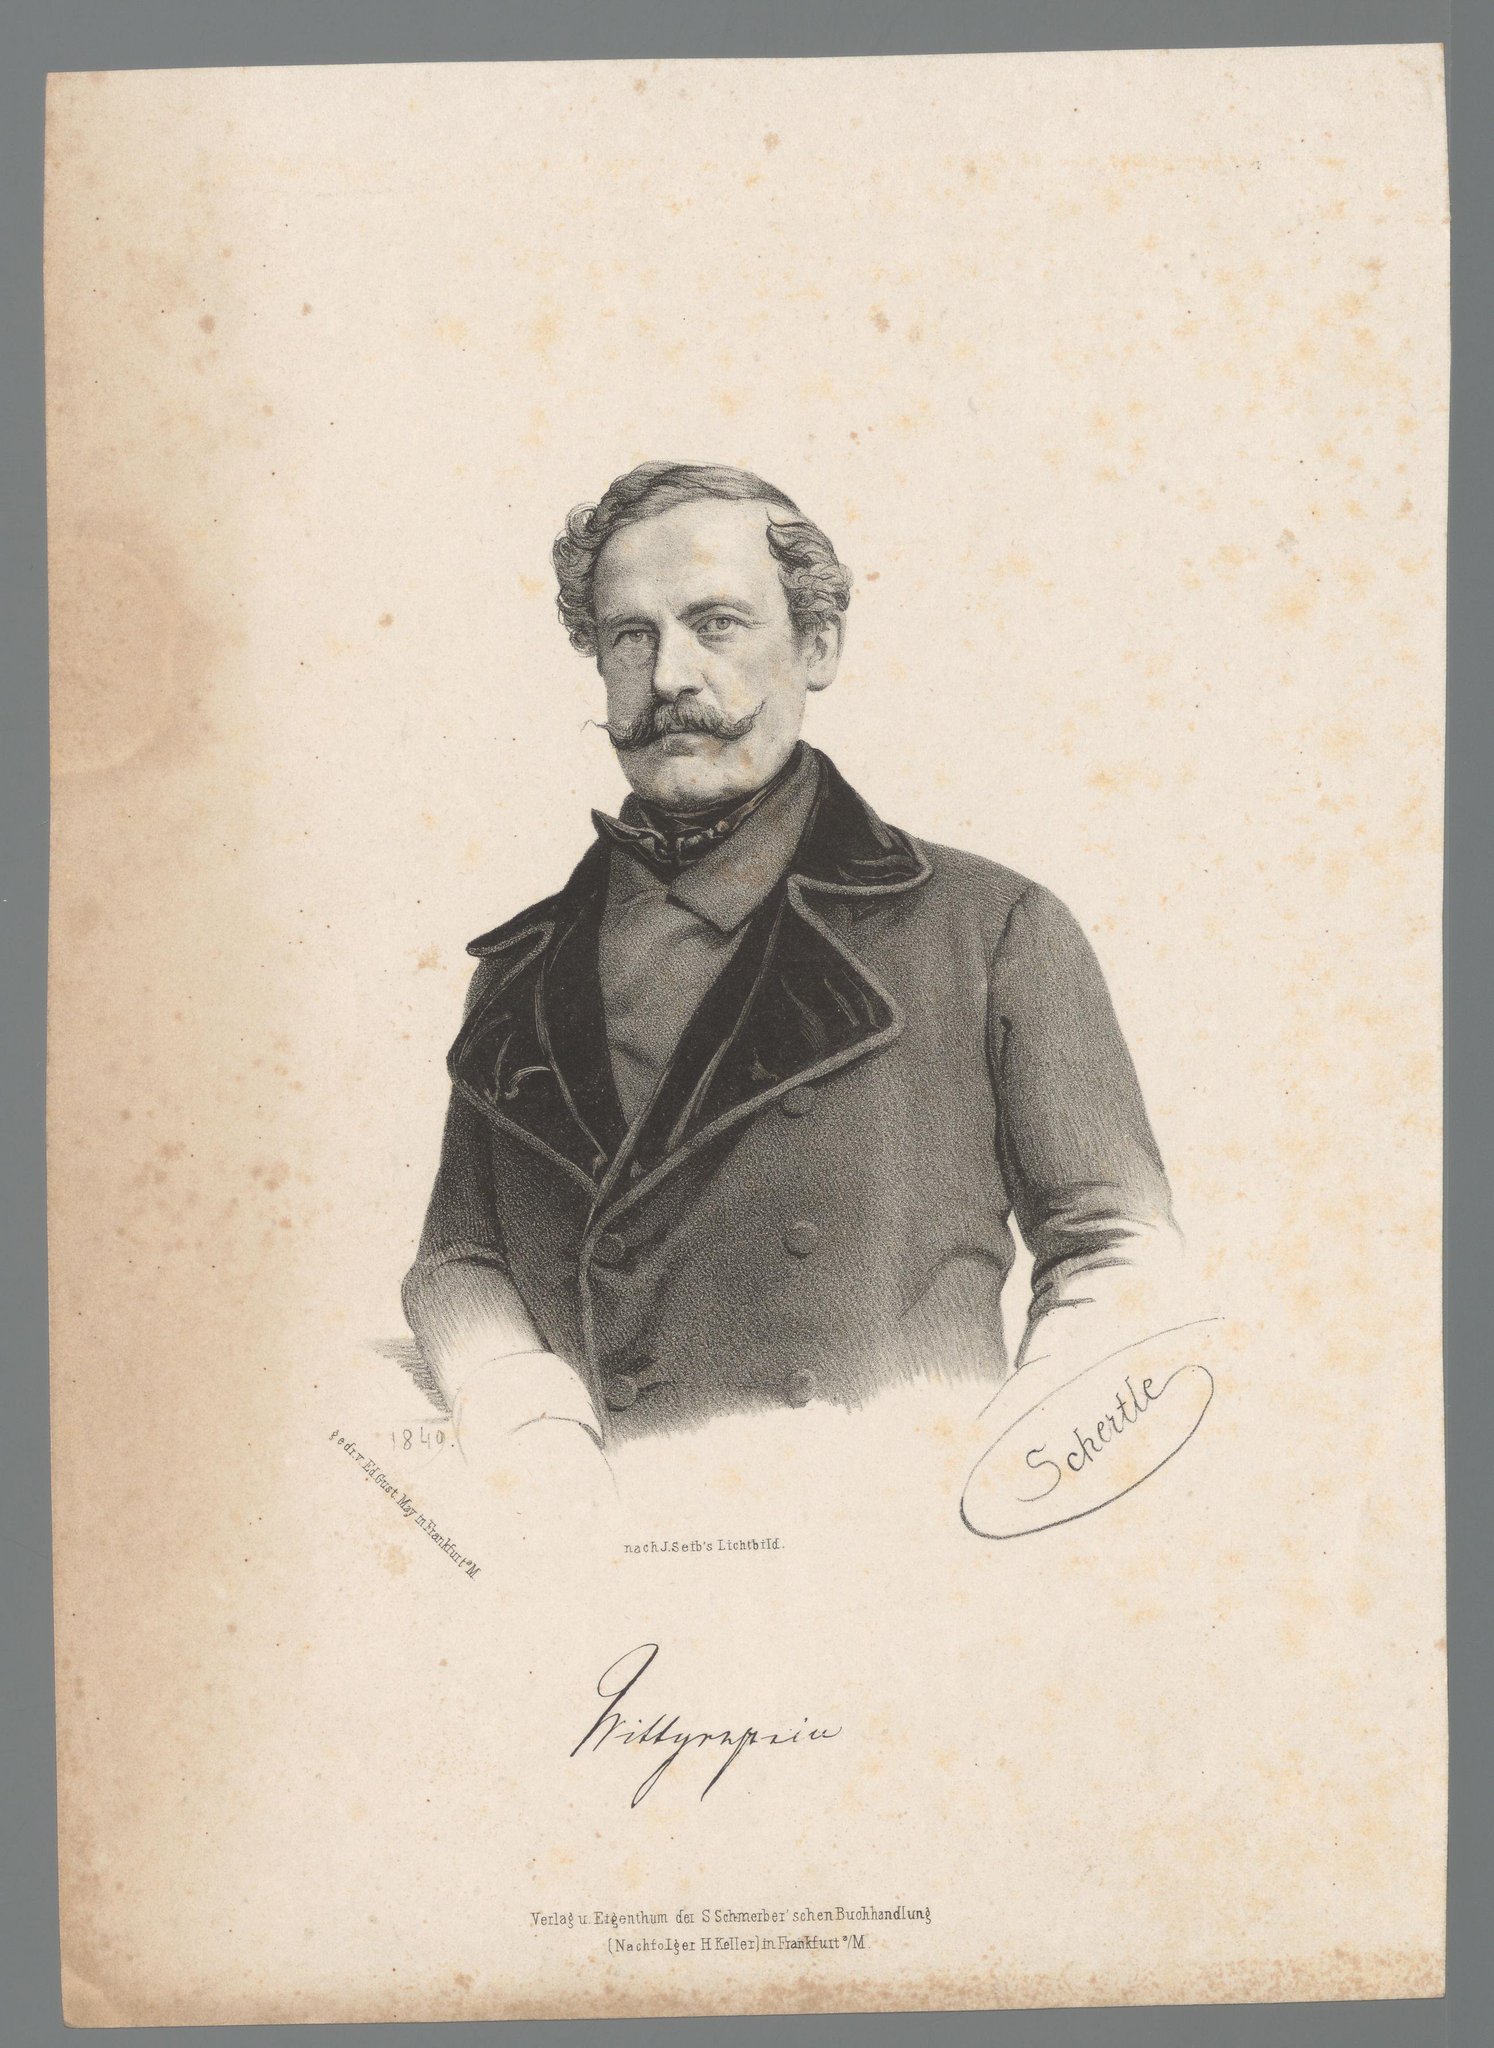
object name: print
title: Portretten van Duitse mannen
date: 1849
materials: paper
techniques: lithograph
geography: frankfurt am main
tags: moustache, adult man, historical persons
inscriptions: collector's mark: Lugt 2228